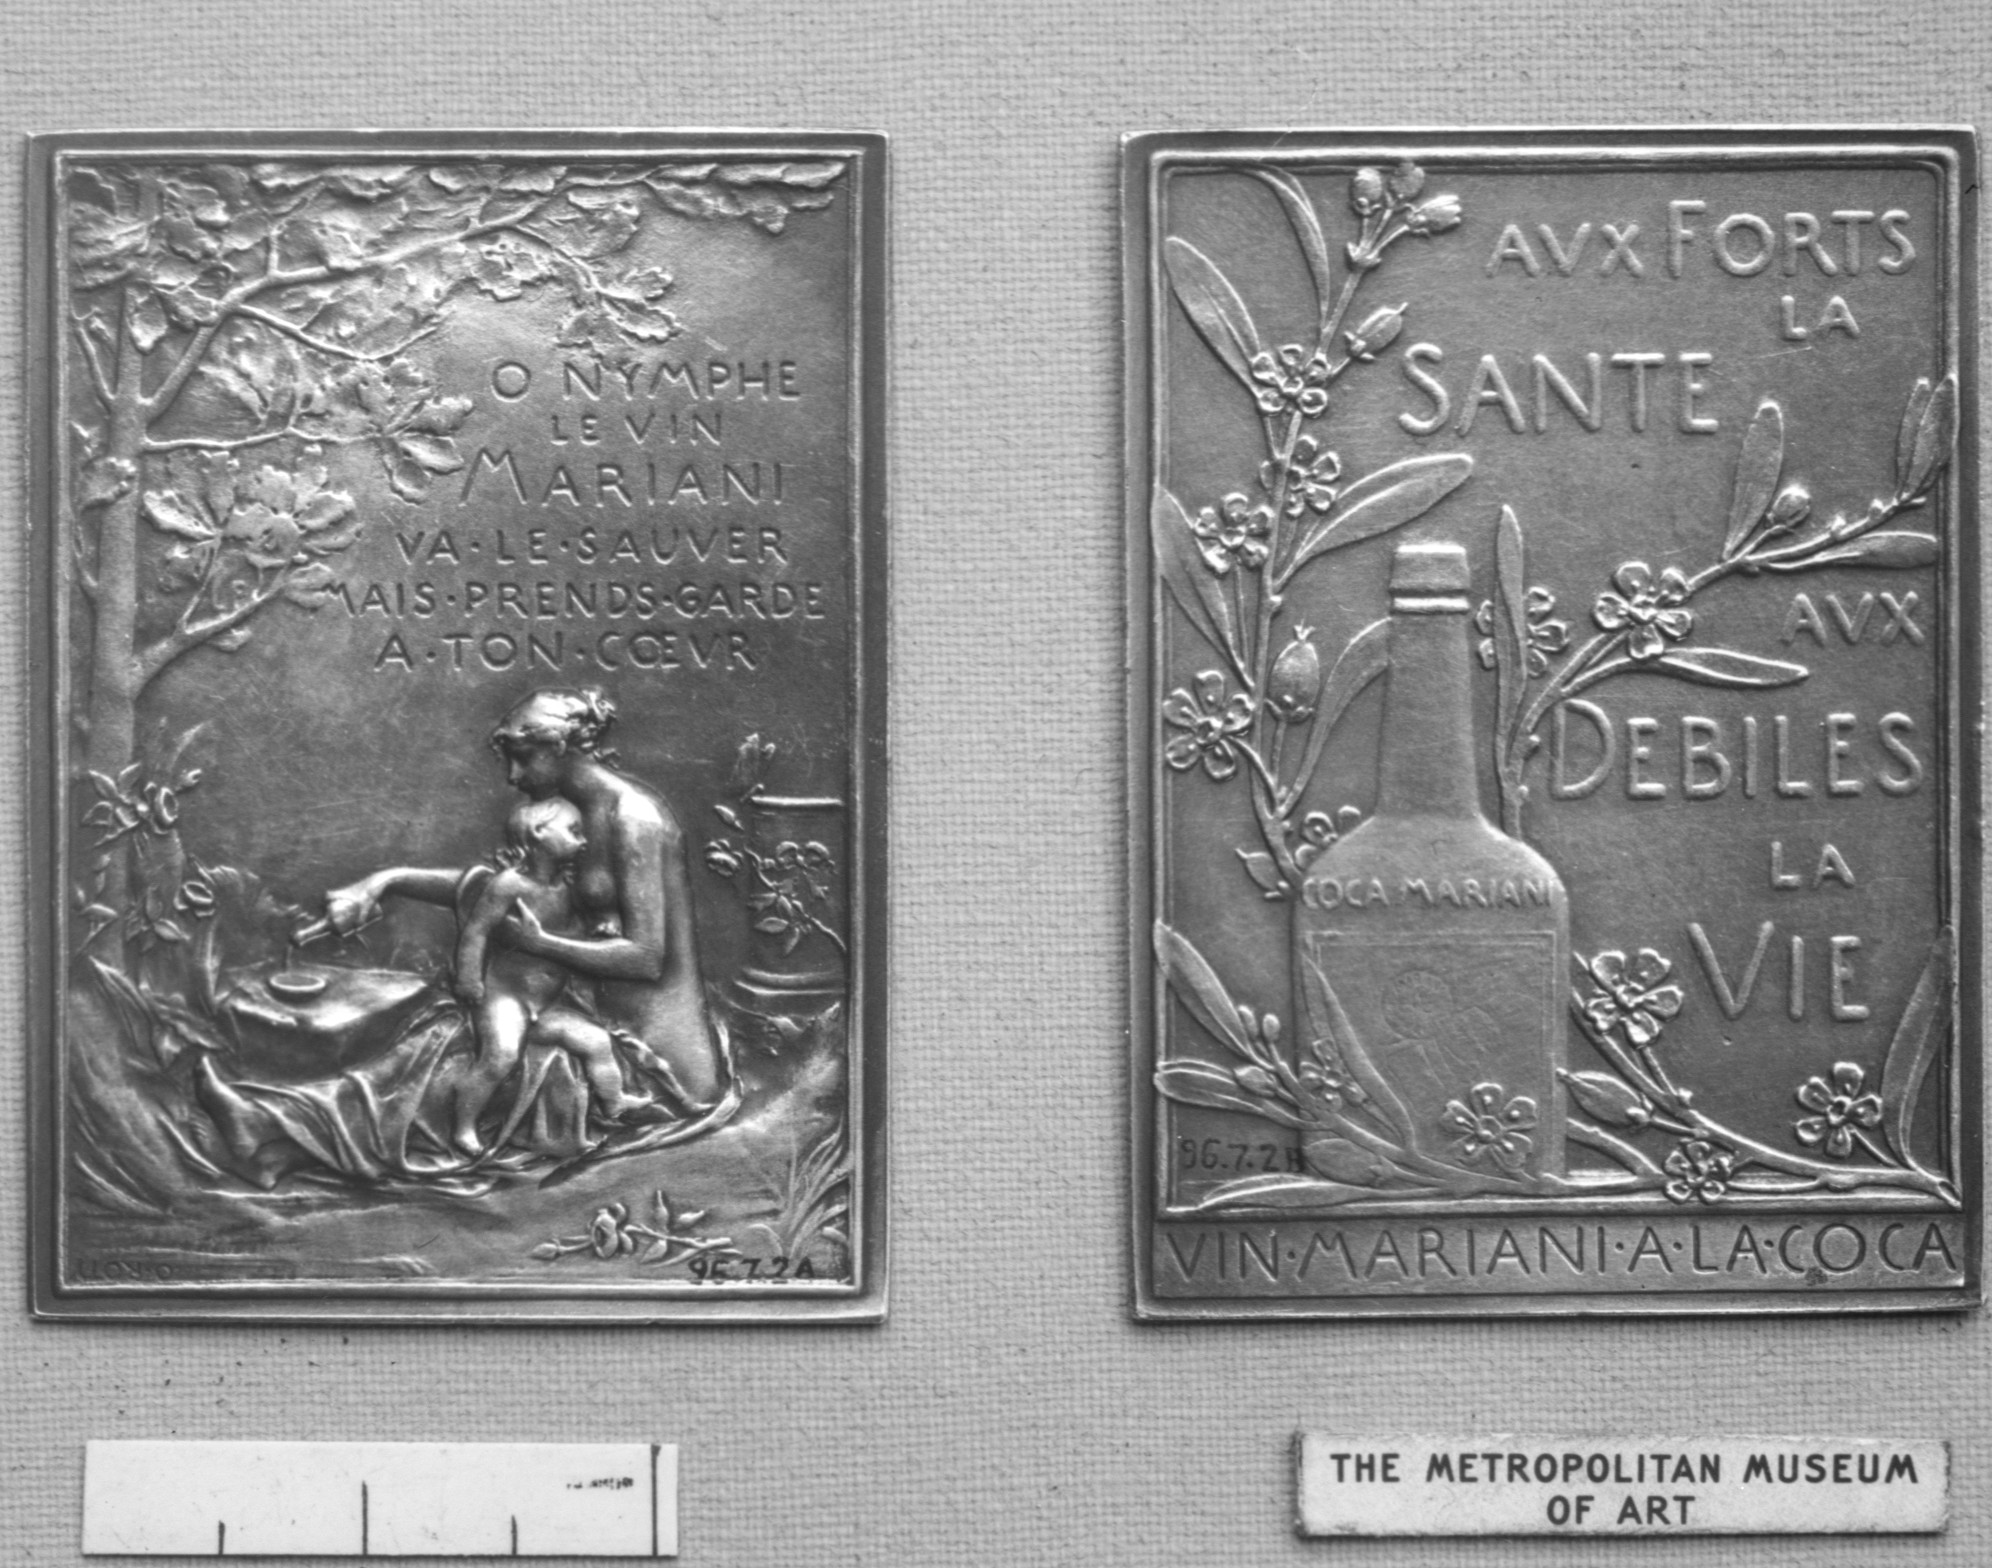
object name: plaquette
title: In Praise of Mariani Coca-Wine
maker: louis-oscar roty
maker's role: artist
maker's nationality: french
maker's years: 1846-1911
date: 1895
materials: bronze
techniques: silvered, struck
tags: wine,children,mothers,trees